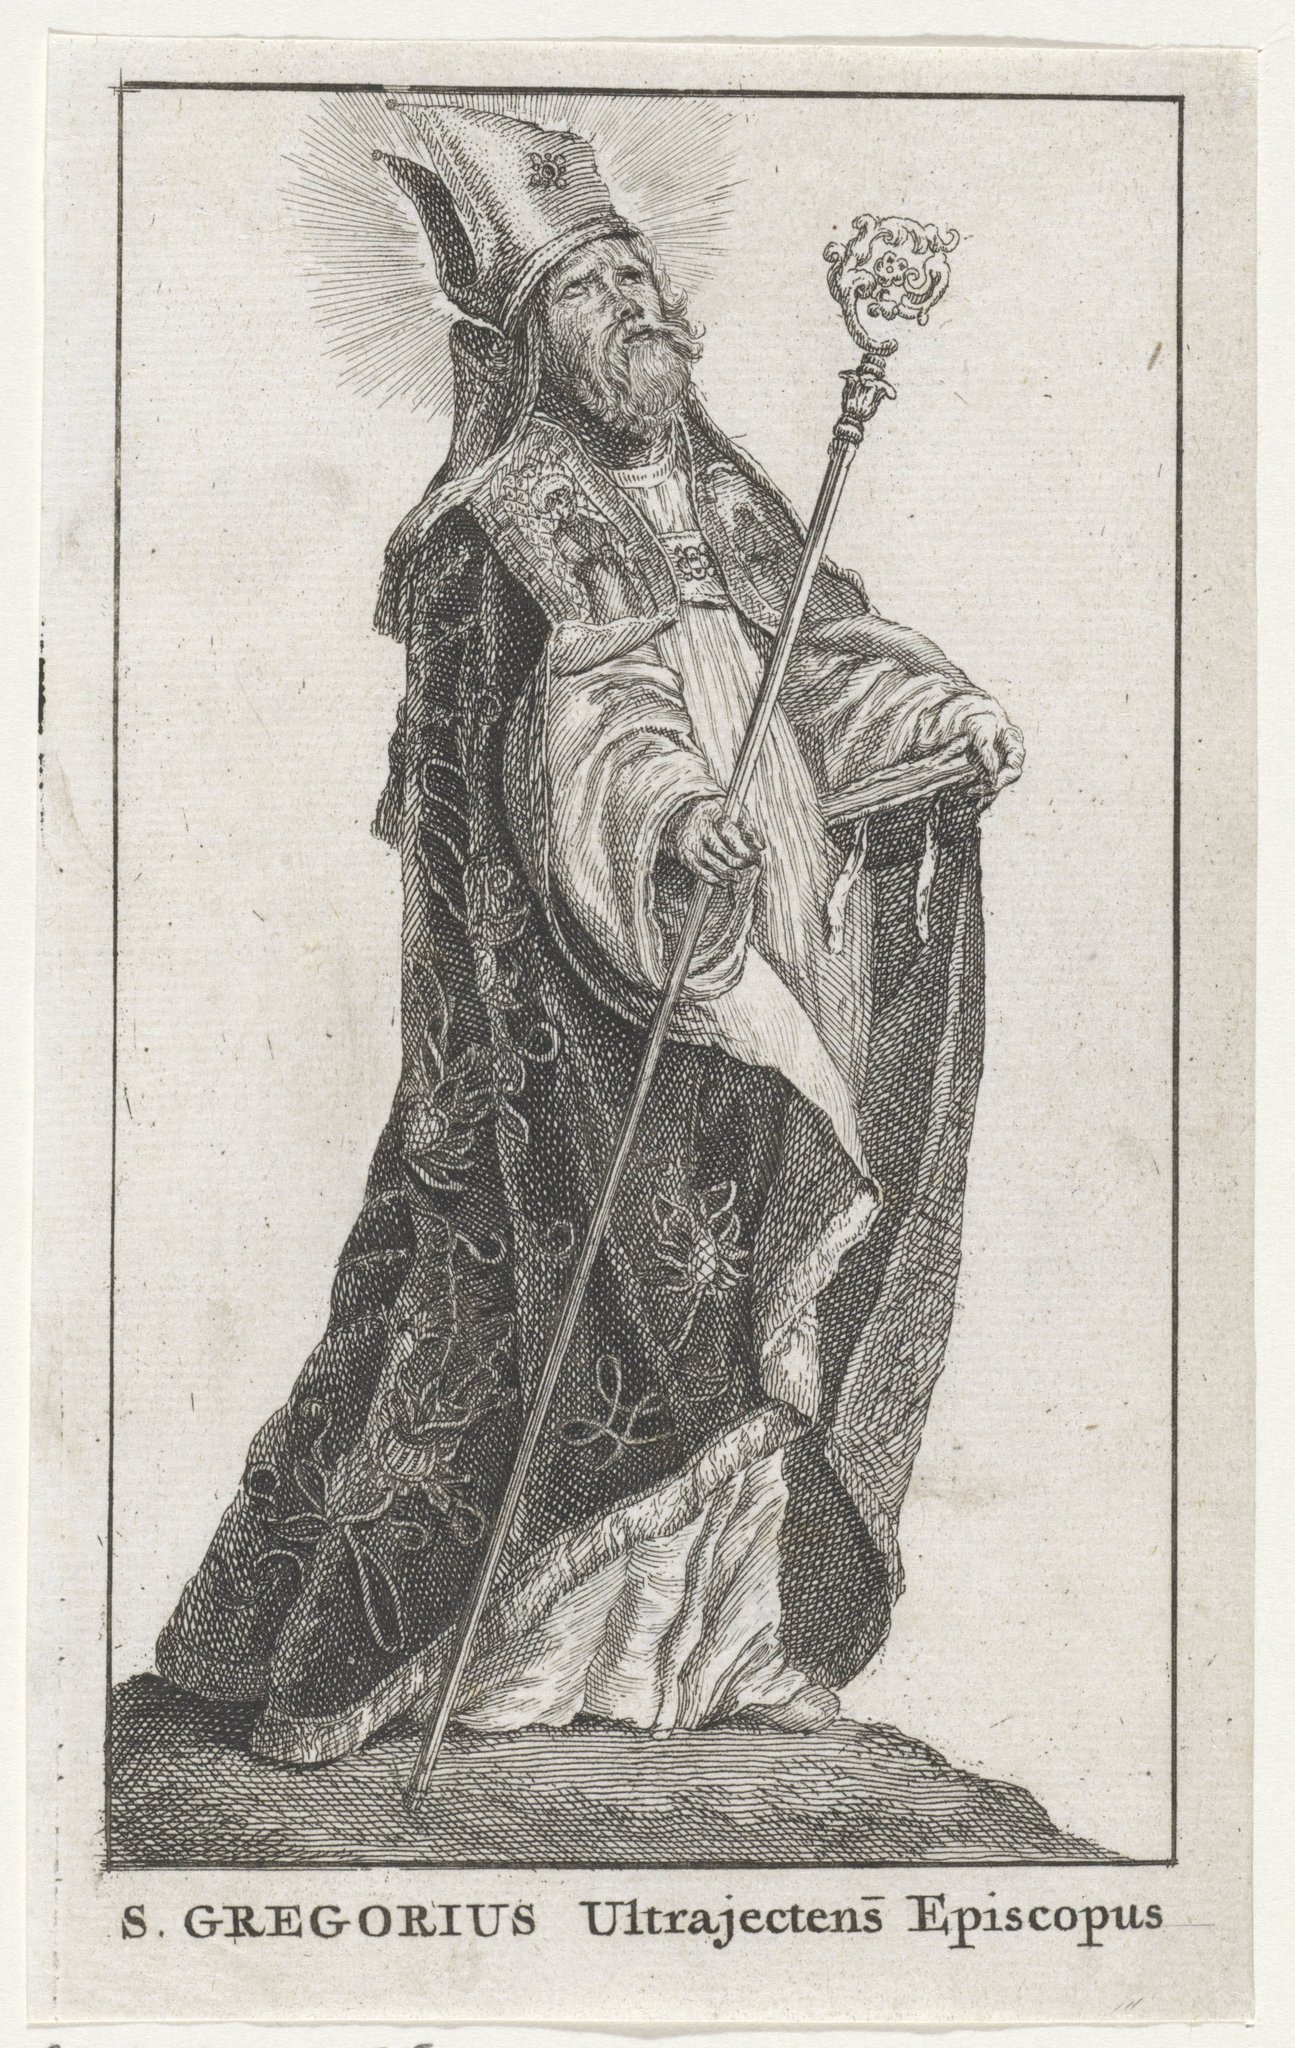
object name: print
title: H. Gregorius van Utrecht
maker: Anonymous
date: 1638-1708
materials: paper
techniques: etching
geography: haarlem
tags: heilige, gregorius van utrecht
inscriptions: collector's mark: Lugt 2228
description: De heilige Gregorius van Utrecht, afgebeeld als een bisschop met mijter en kromstaf.